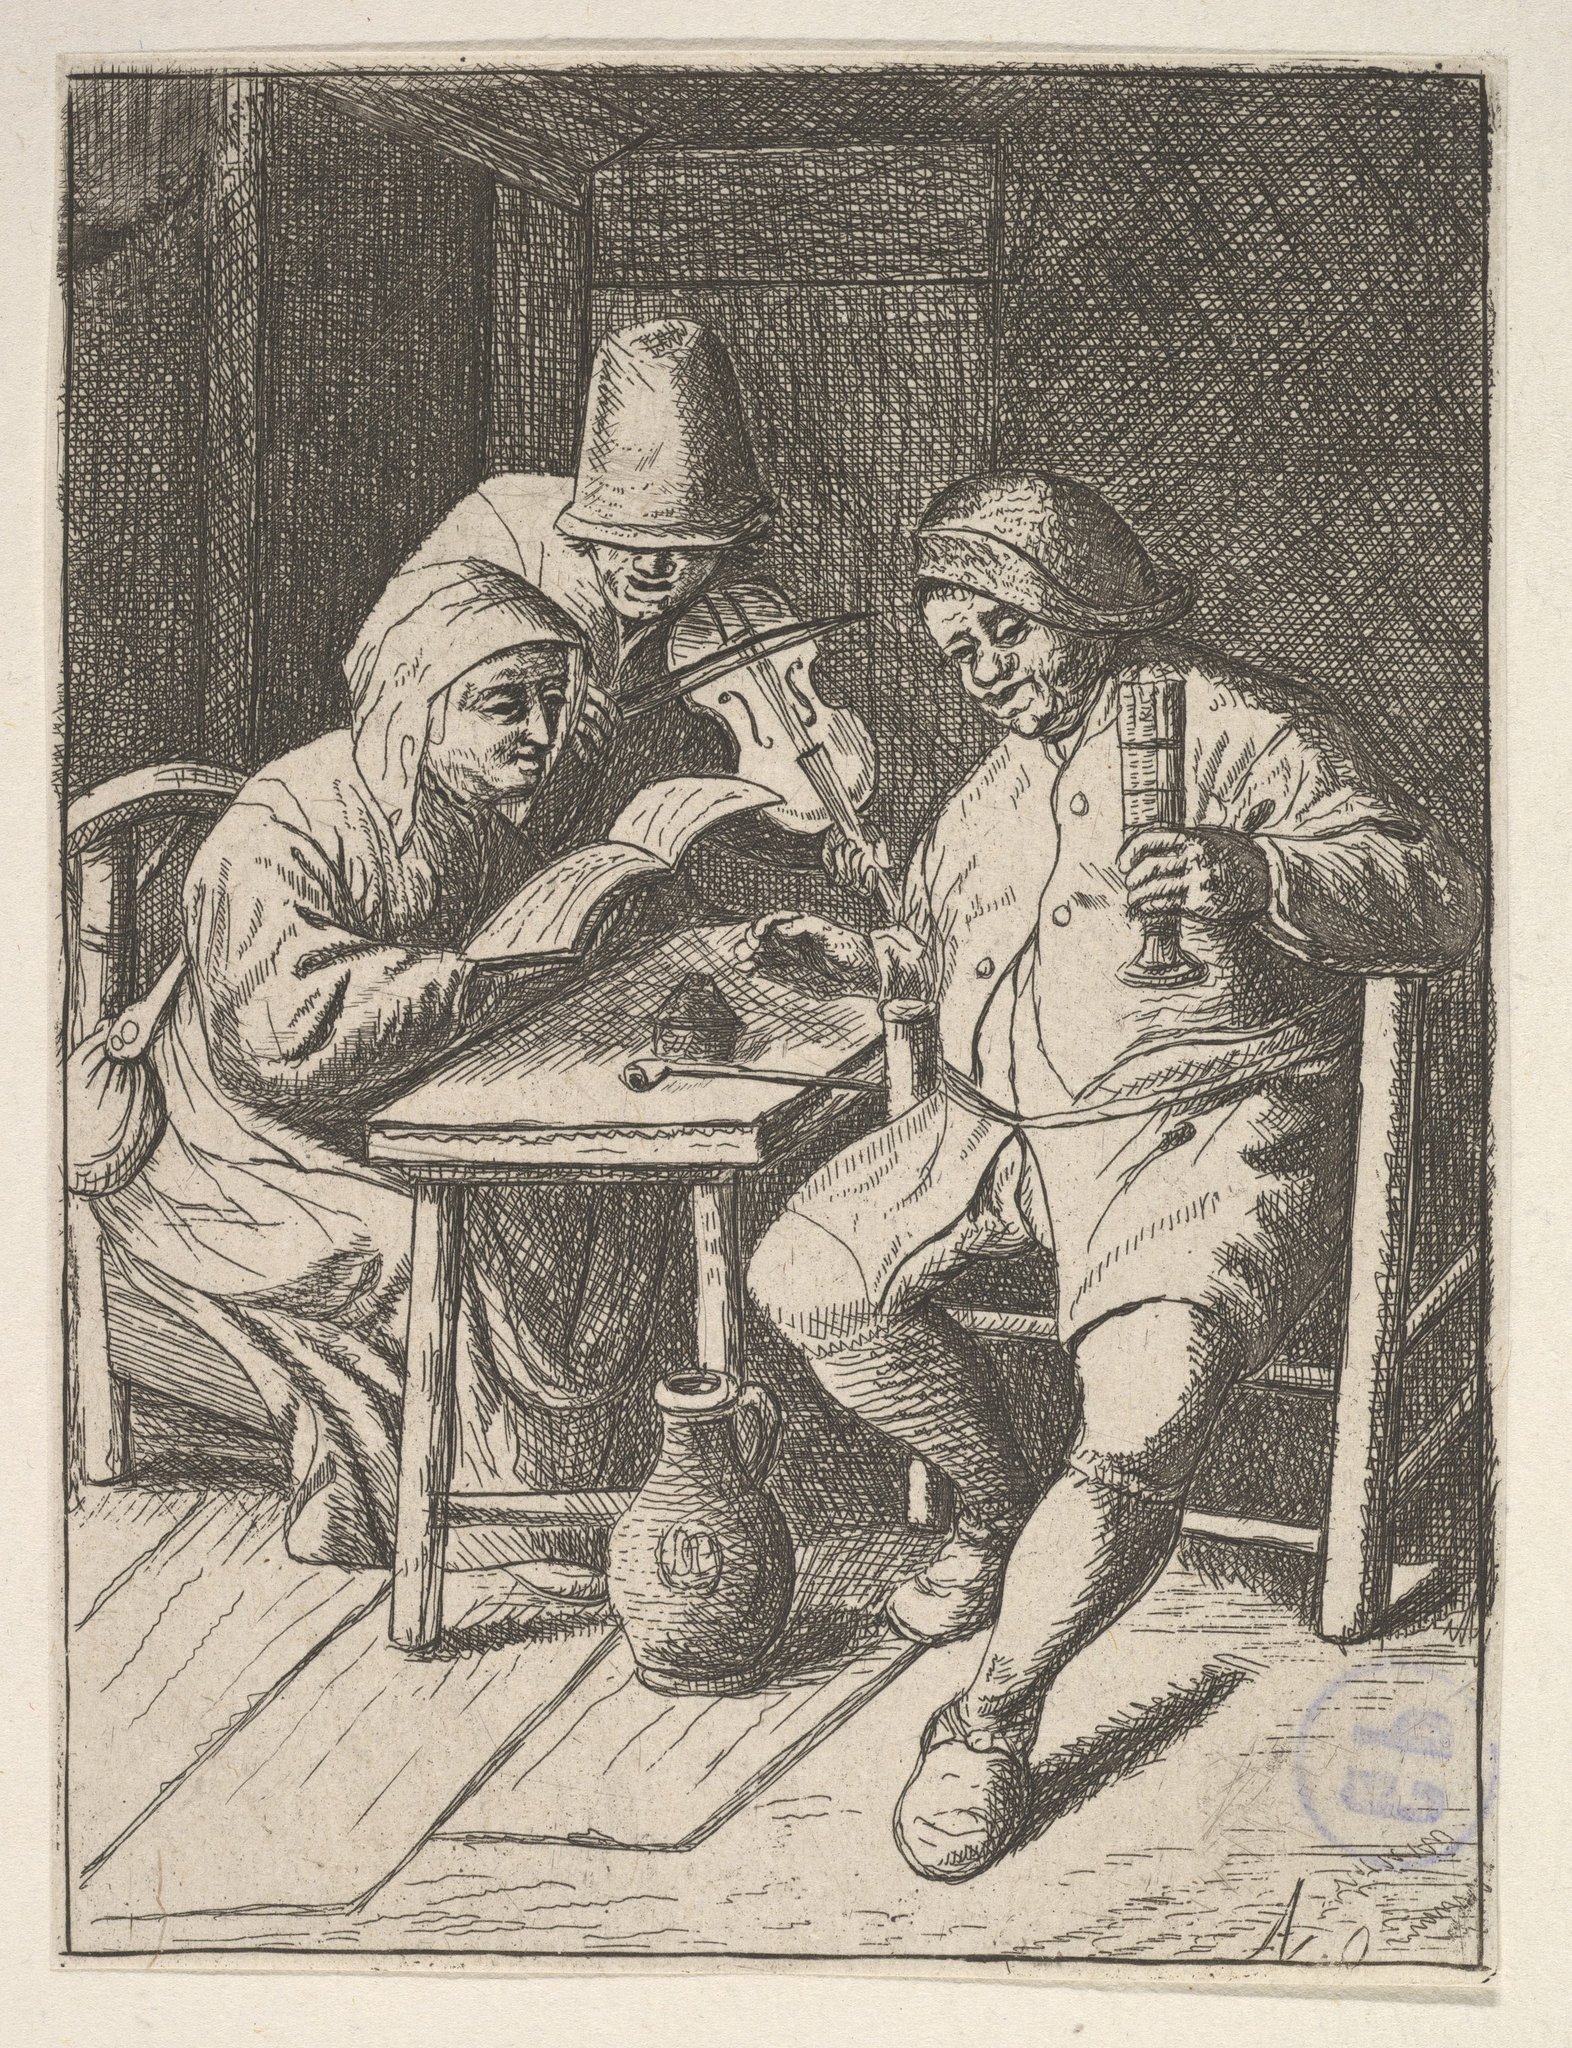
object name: print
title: Singing Couples and Violin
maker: adriaen van ostade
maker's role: artist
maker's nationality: dutch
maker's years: 1610-1685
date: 1610-1685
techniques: etching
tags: couples,men,women,singing,violins